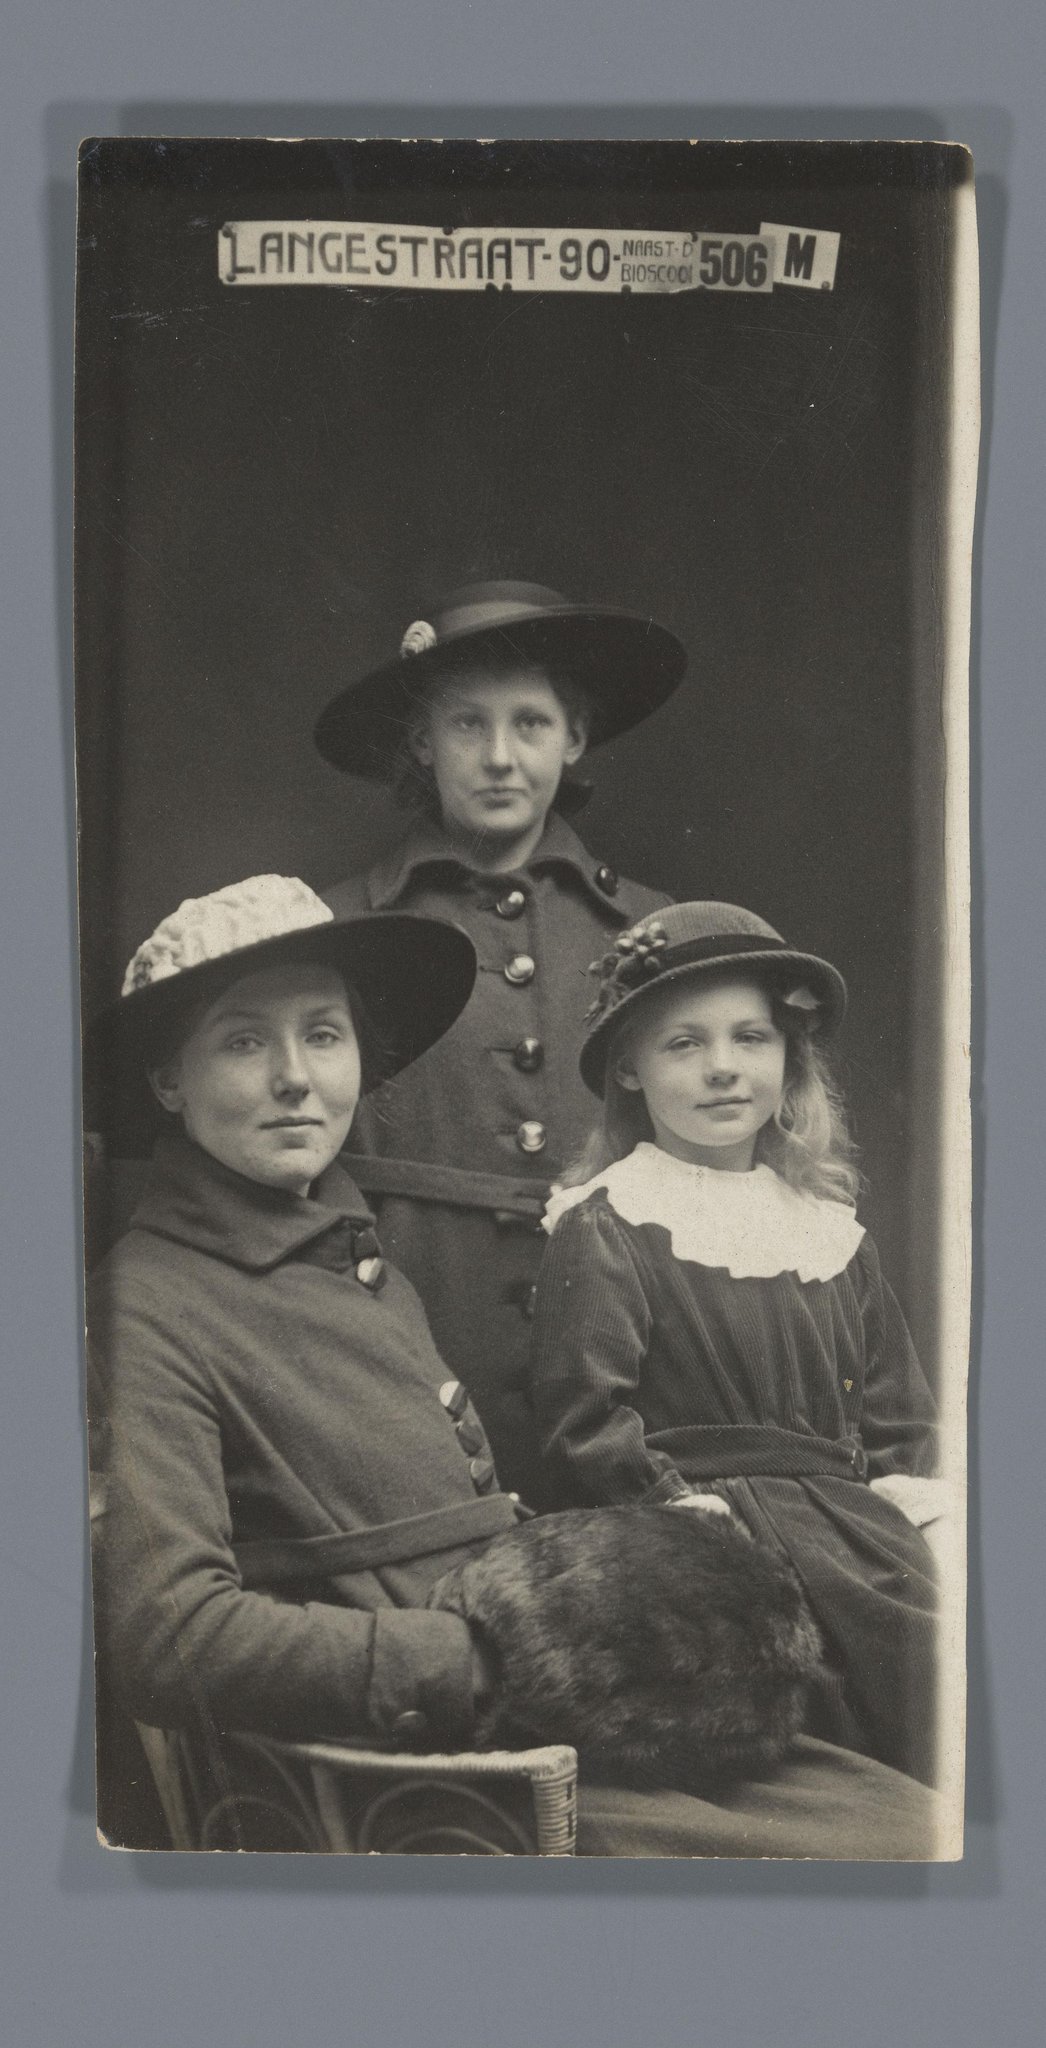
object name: snapshot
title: Portret van twee vrouwen en een meisje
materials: photographic support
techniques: gelatin silver print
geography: alkmaar